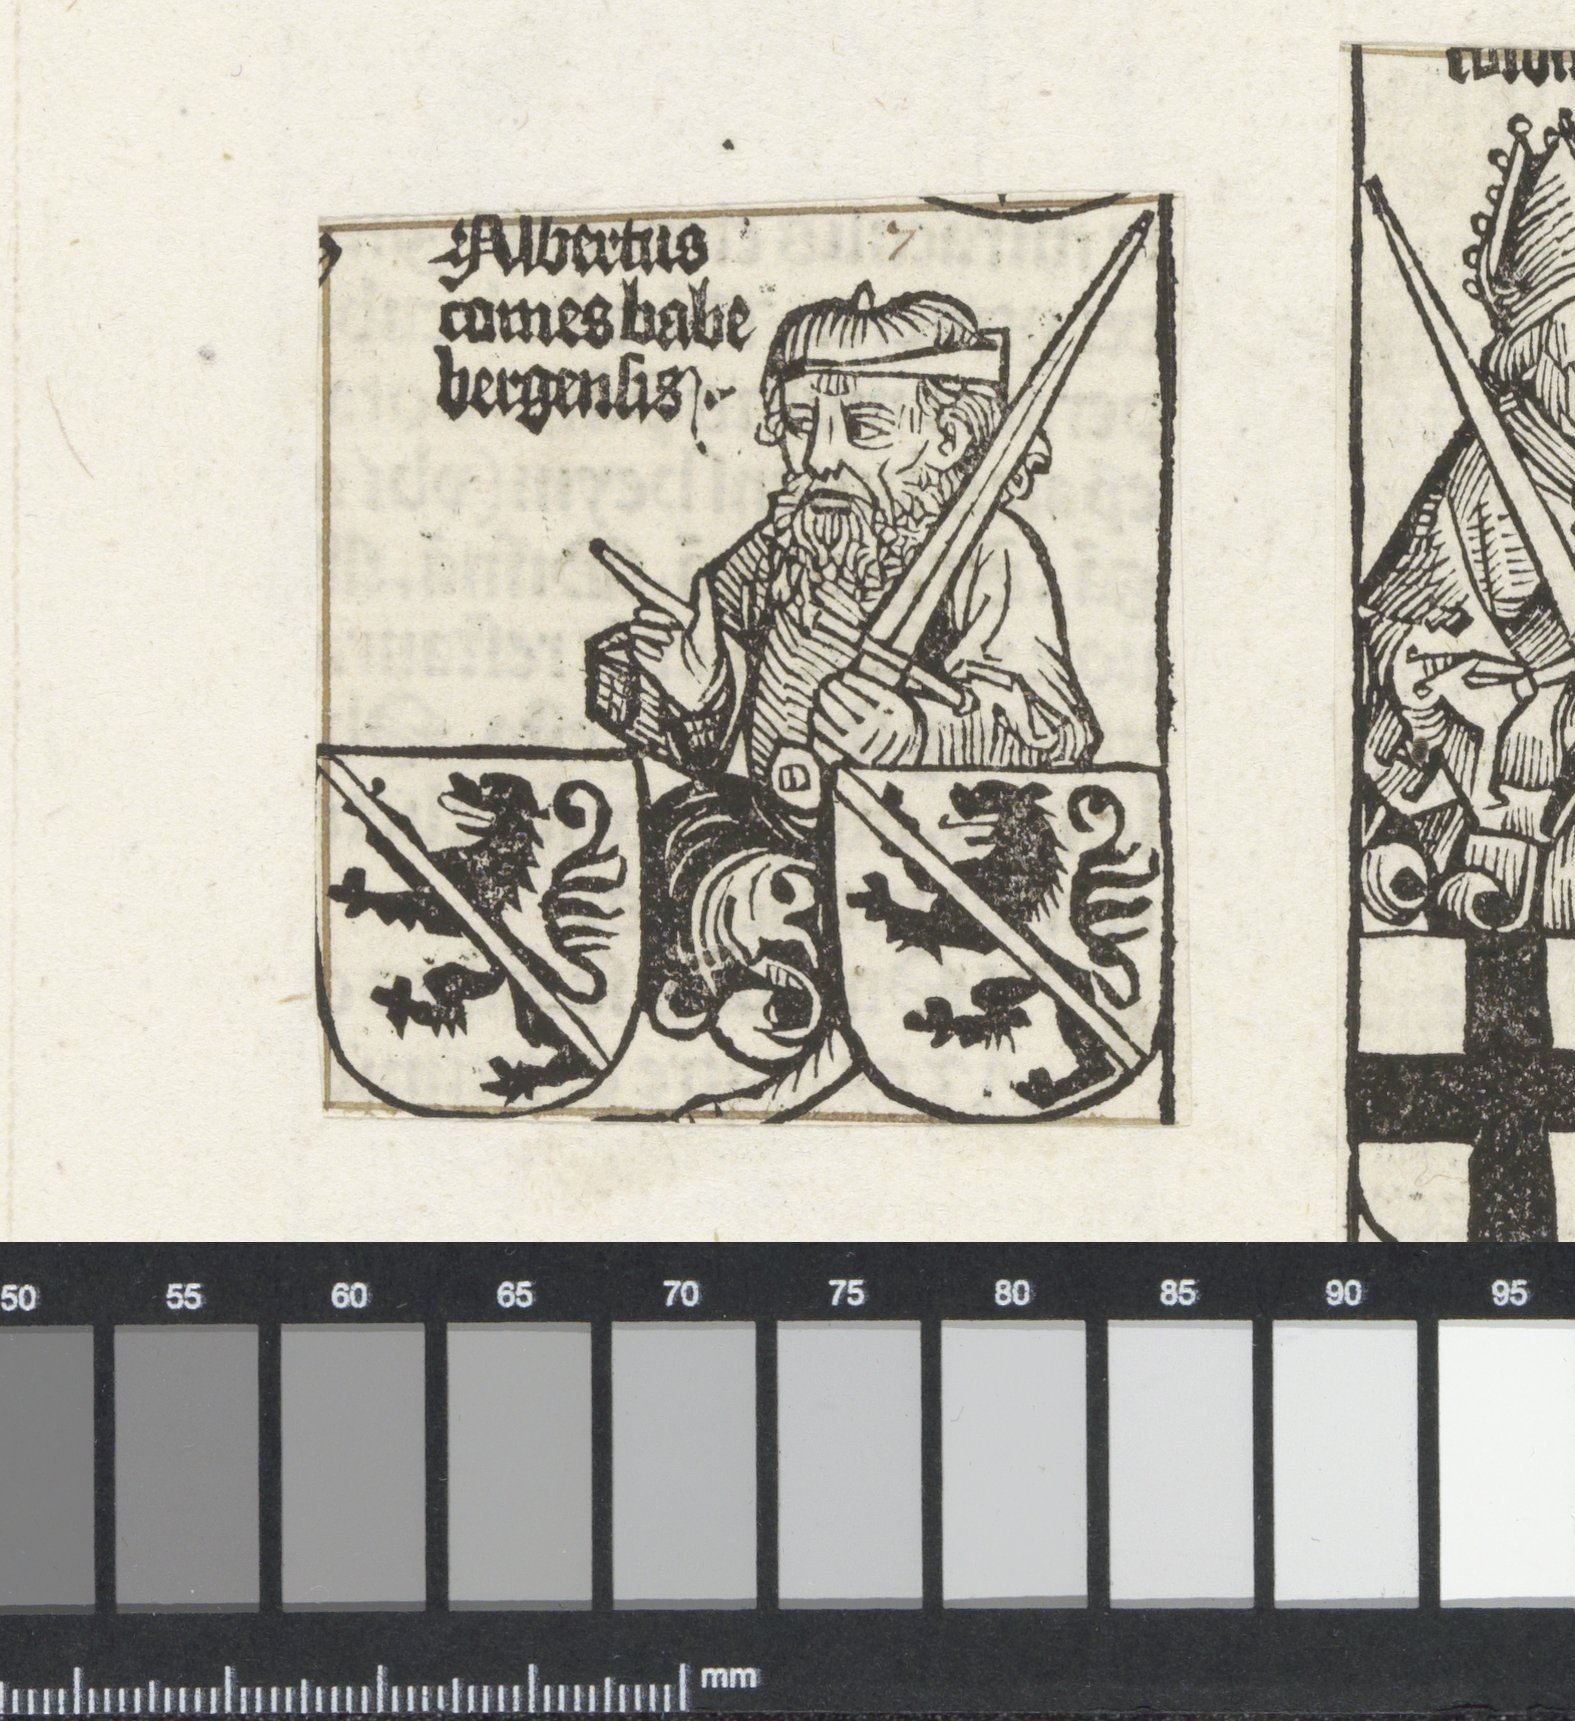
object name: book illustration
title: Albertus comes babebergensis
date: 1493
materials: paper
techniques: letterpress printing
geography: nuremberg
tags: armorial bearing, heraldry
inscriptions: inscription: ‘7’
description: Een bloemkelk met een man, naar links gekeerd en met een zwaard in de handen. De wapenschilden hebben een zwarte klimmende leeuw met een diagonale streep. De voorstelling is onderdeel van de stamboom van keizer Hendrik II de Heilige in de Liber Chronicarum. De tekst identificeert de persoon als graaf Albrecht van Babenberg, kleinzoon van Otto I van Saksen. De prent maakt deel uit van een album.